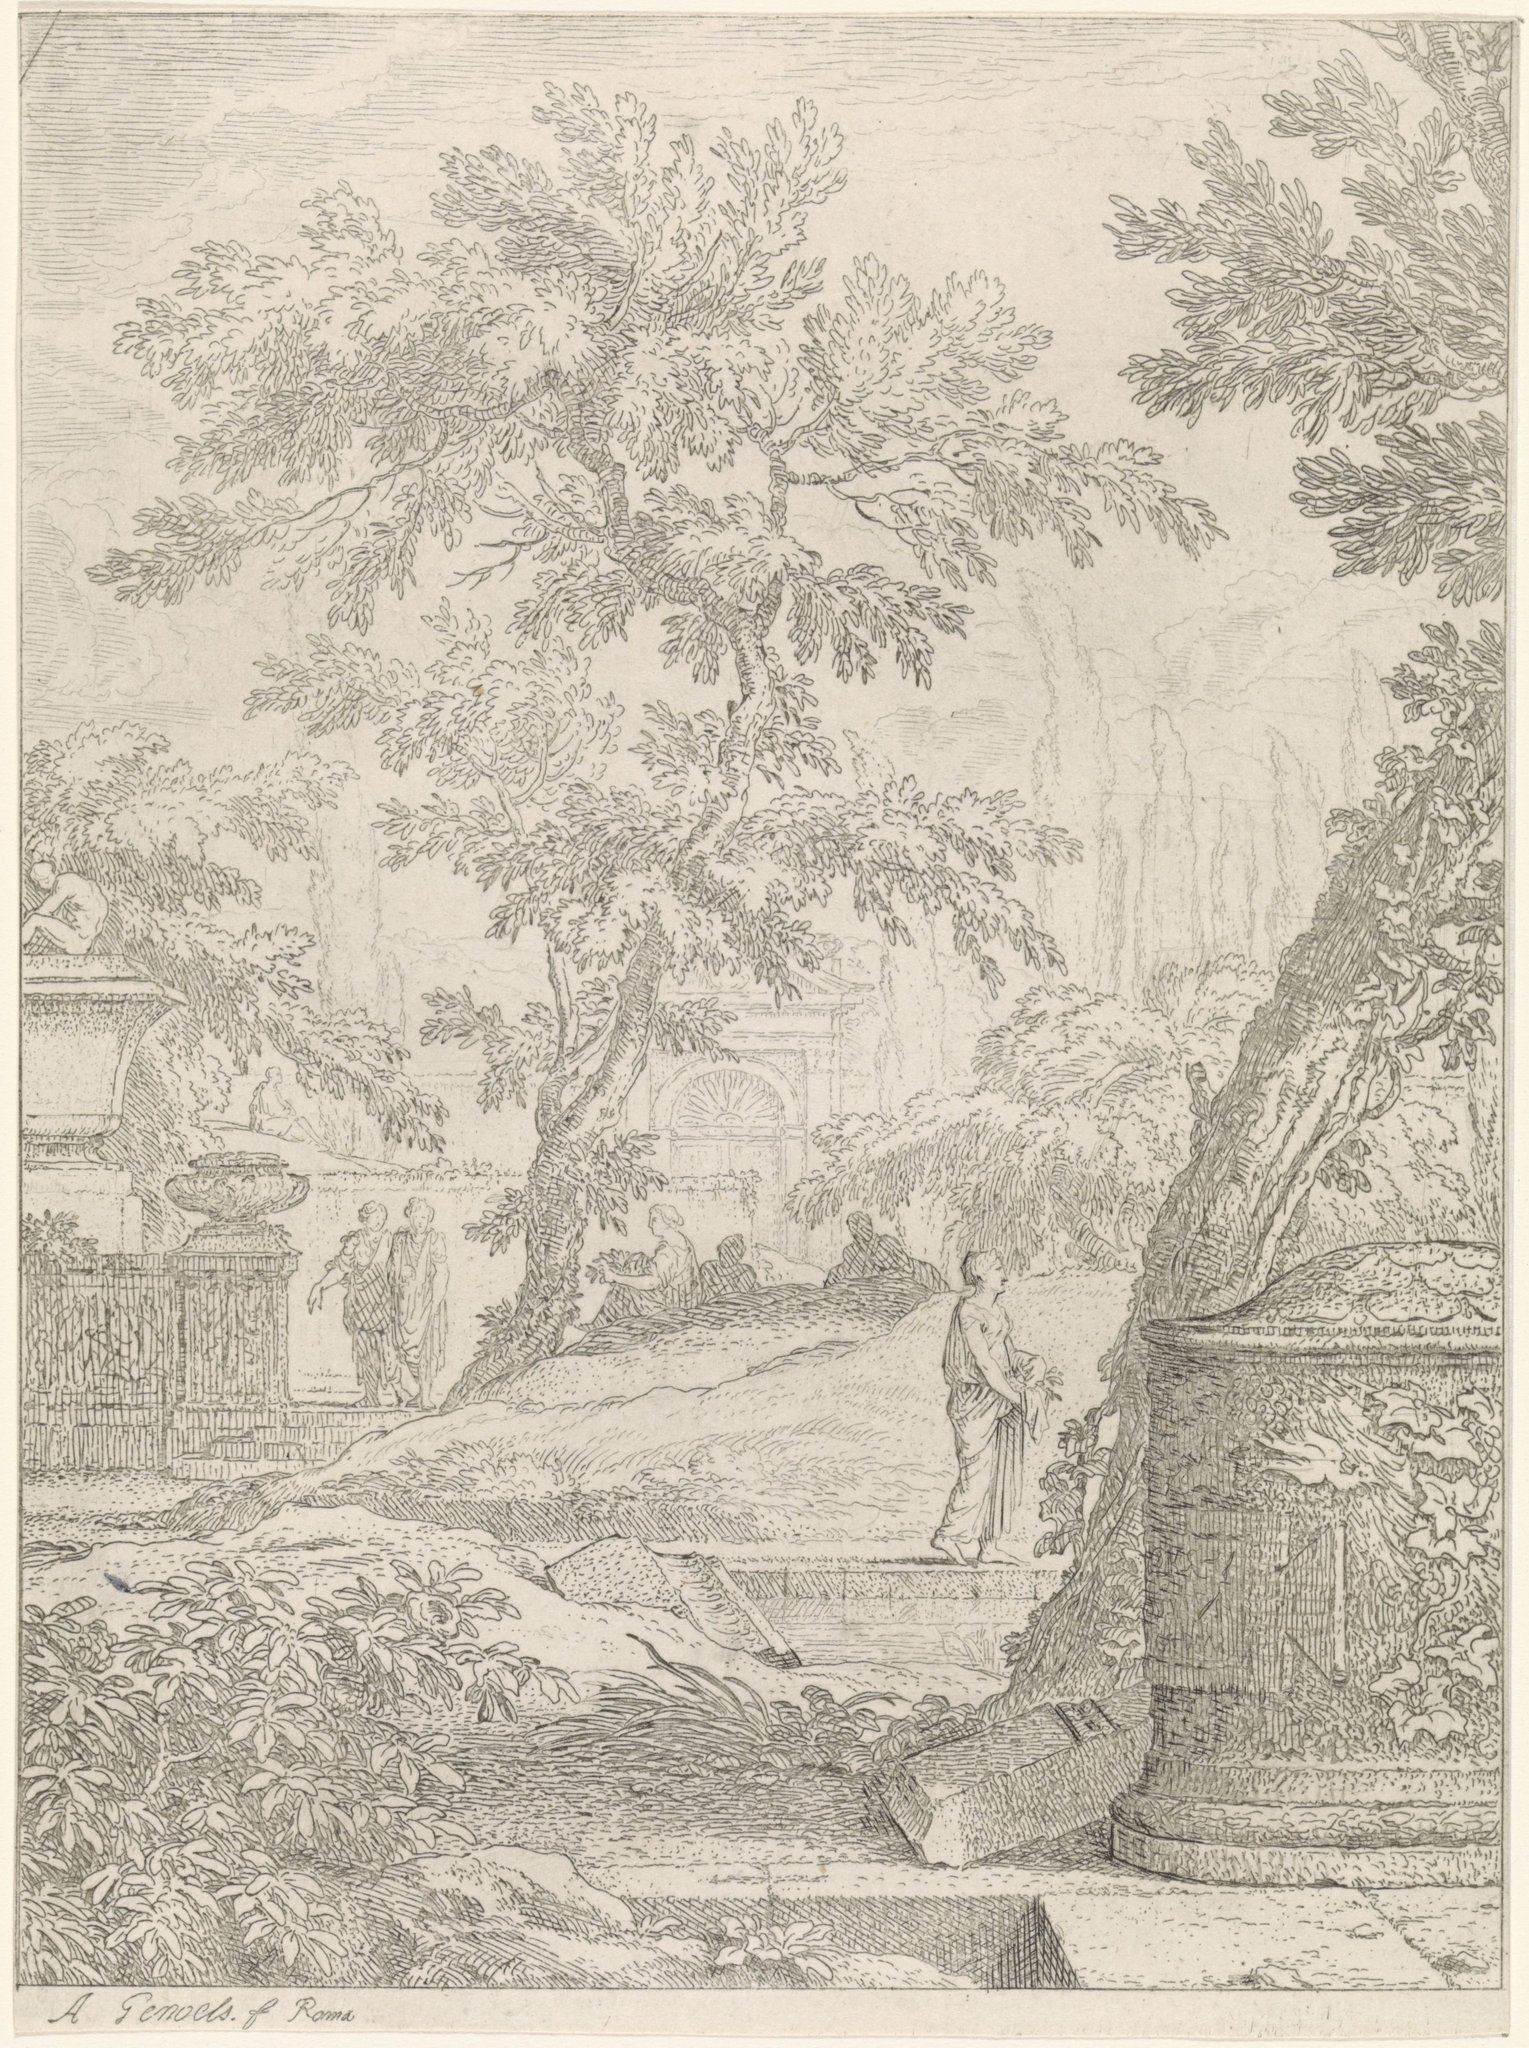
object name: print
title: Mausoleum in Arcadisch landschap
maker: abraham genoels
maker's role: draughtsman, print maker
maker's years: 1640-1723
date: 1650-1723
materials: paper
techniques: etching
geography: rome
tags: garden, mausoleum, garden ornaments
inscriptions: collector's mark: Lugt 240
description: Een Arcadisch landschap. Enkele figuren wandelen rond in een tuin met klassieke architectuur en een mausoleum.